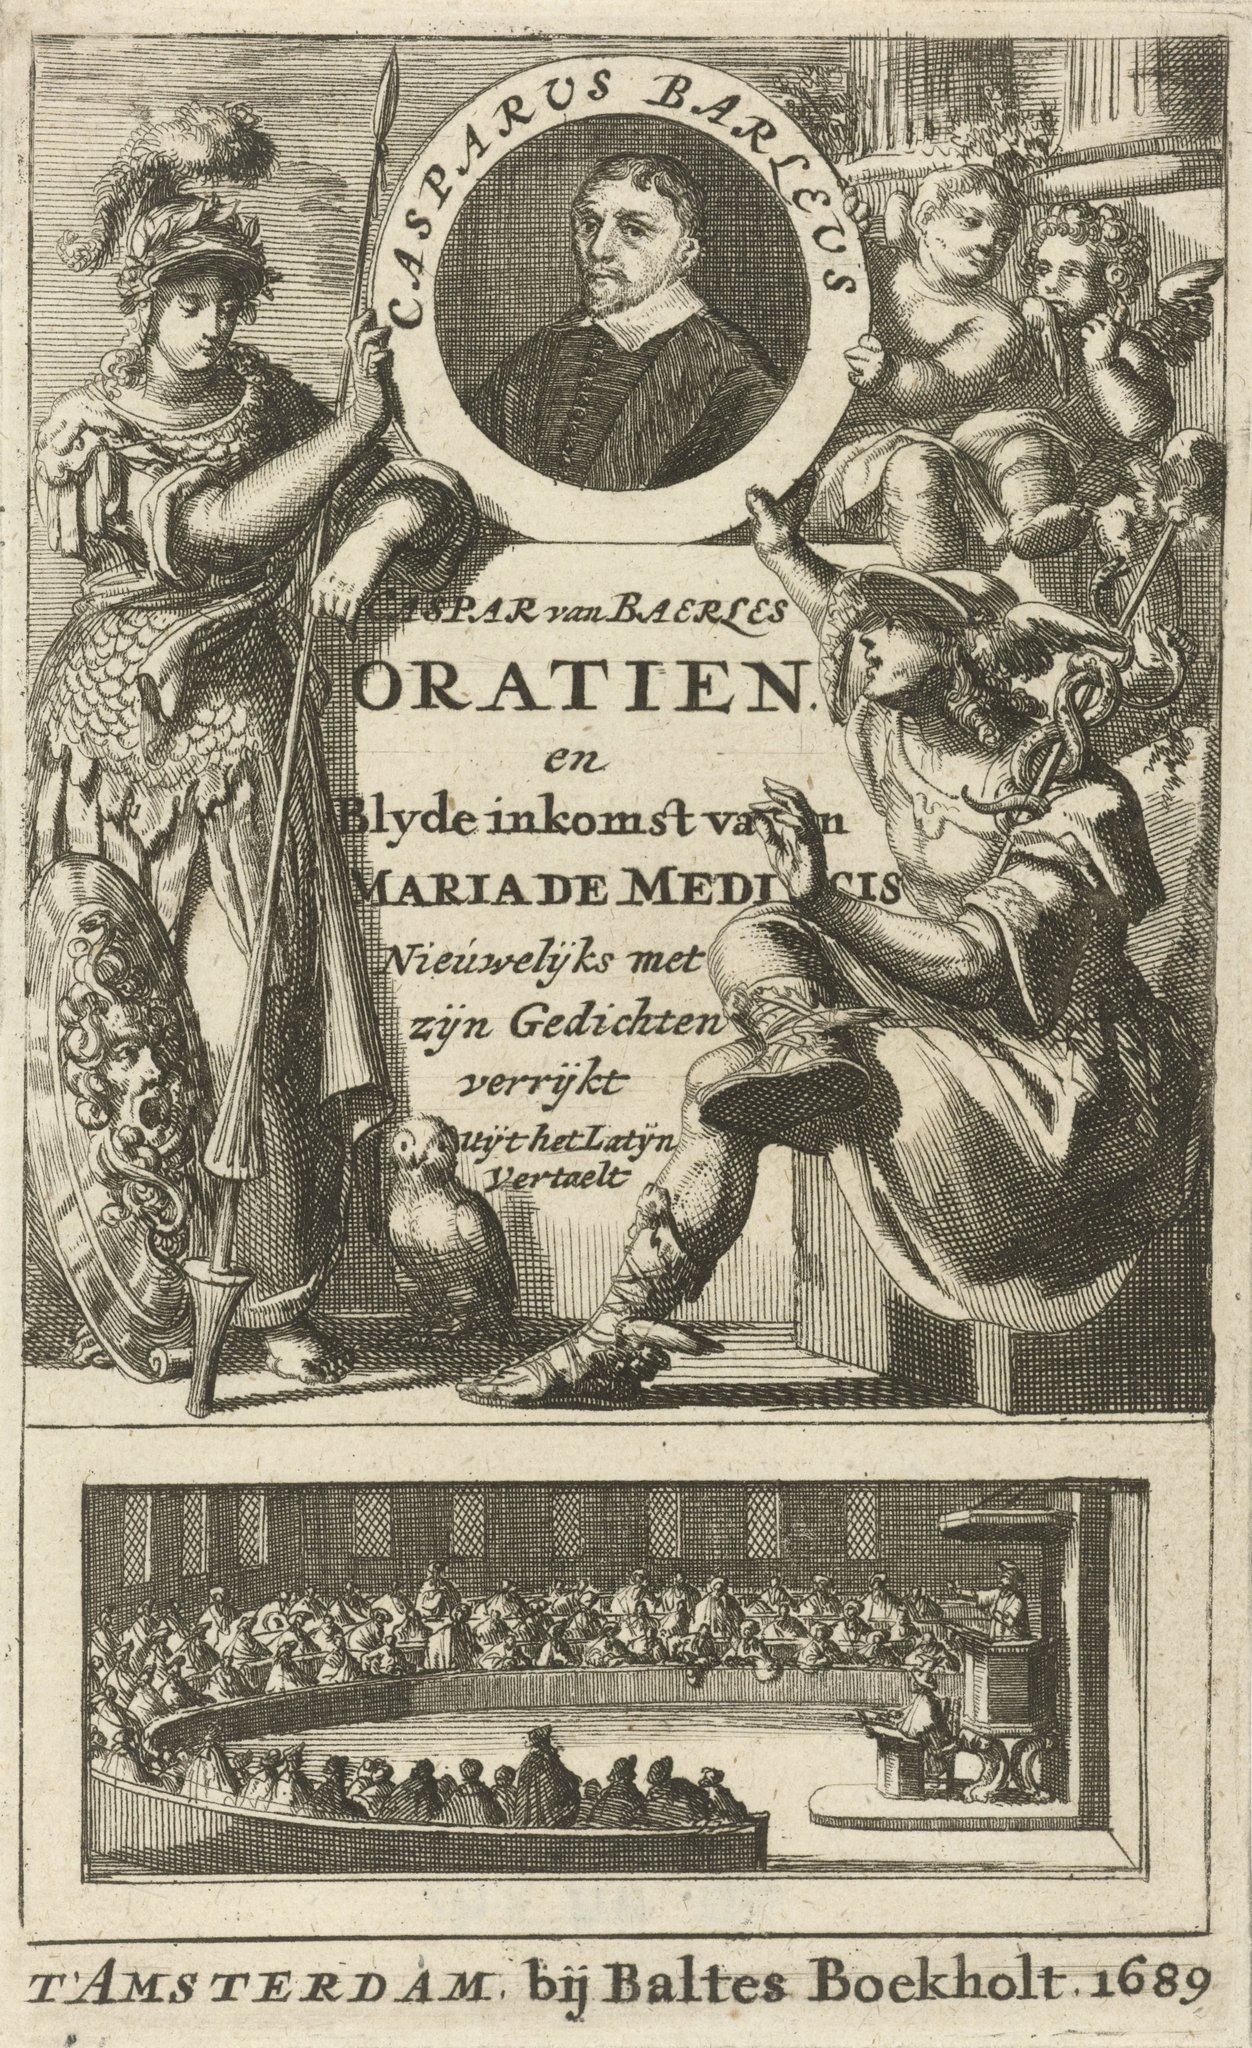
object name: print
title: Minerva en Mercurius houden samen met een engel het portret van Caspar Barlaeus vast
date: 1689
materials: paper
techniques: etching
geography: amsterdam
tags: antwerp, caspar van baerle, (story of) minerva (pallas, athena), (story of) mercury (hermes), cupids: 'amores', 'amoretti', 'putti'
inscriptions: collector's mark: Lugt 2228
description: Titelpagina voor: Barlaeus, Caspar. Oratien en Blĳde inkomst van Maria de Medicis. Amsterdam: Baltes Boekholt, 1689.